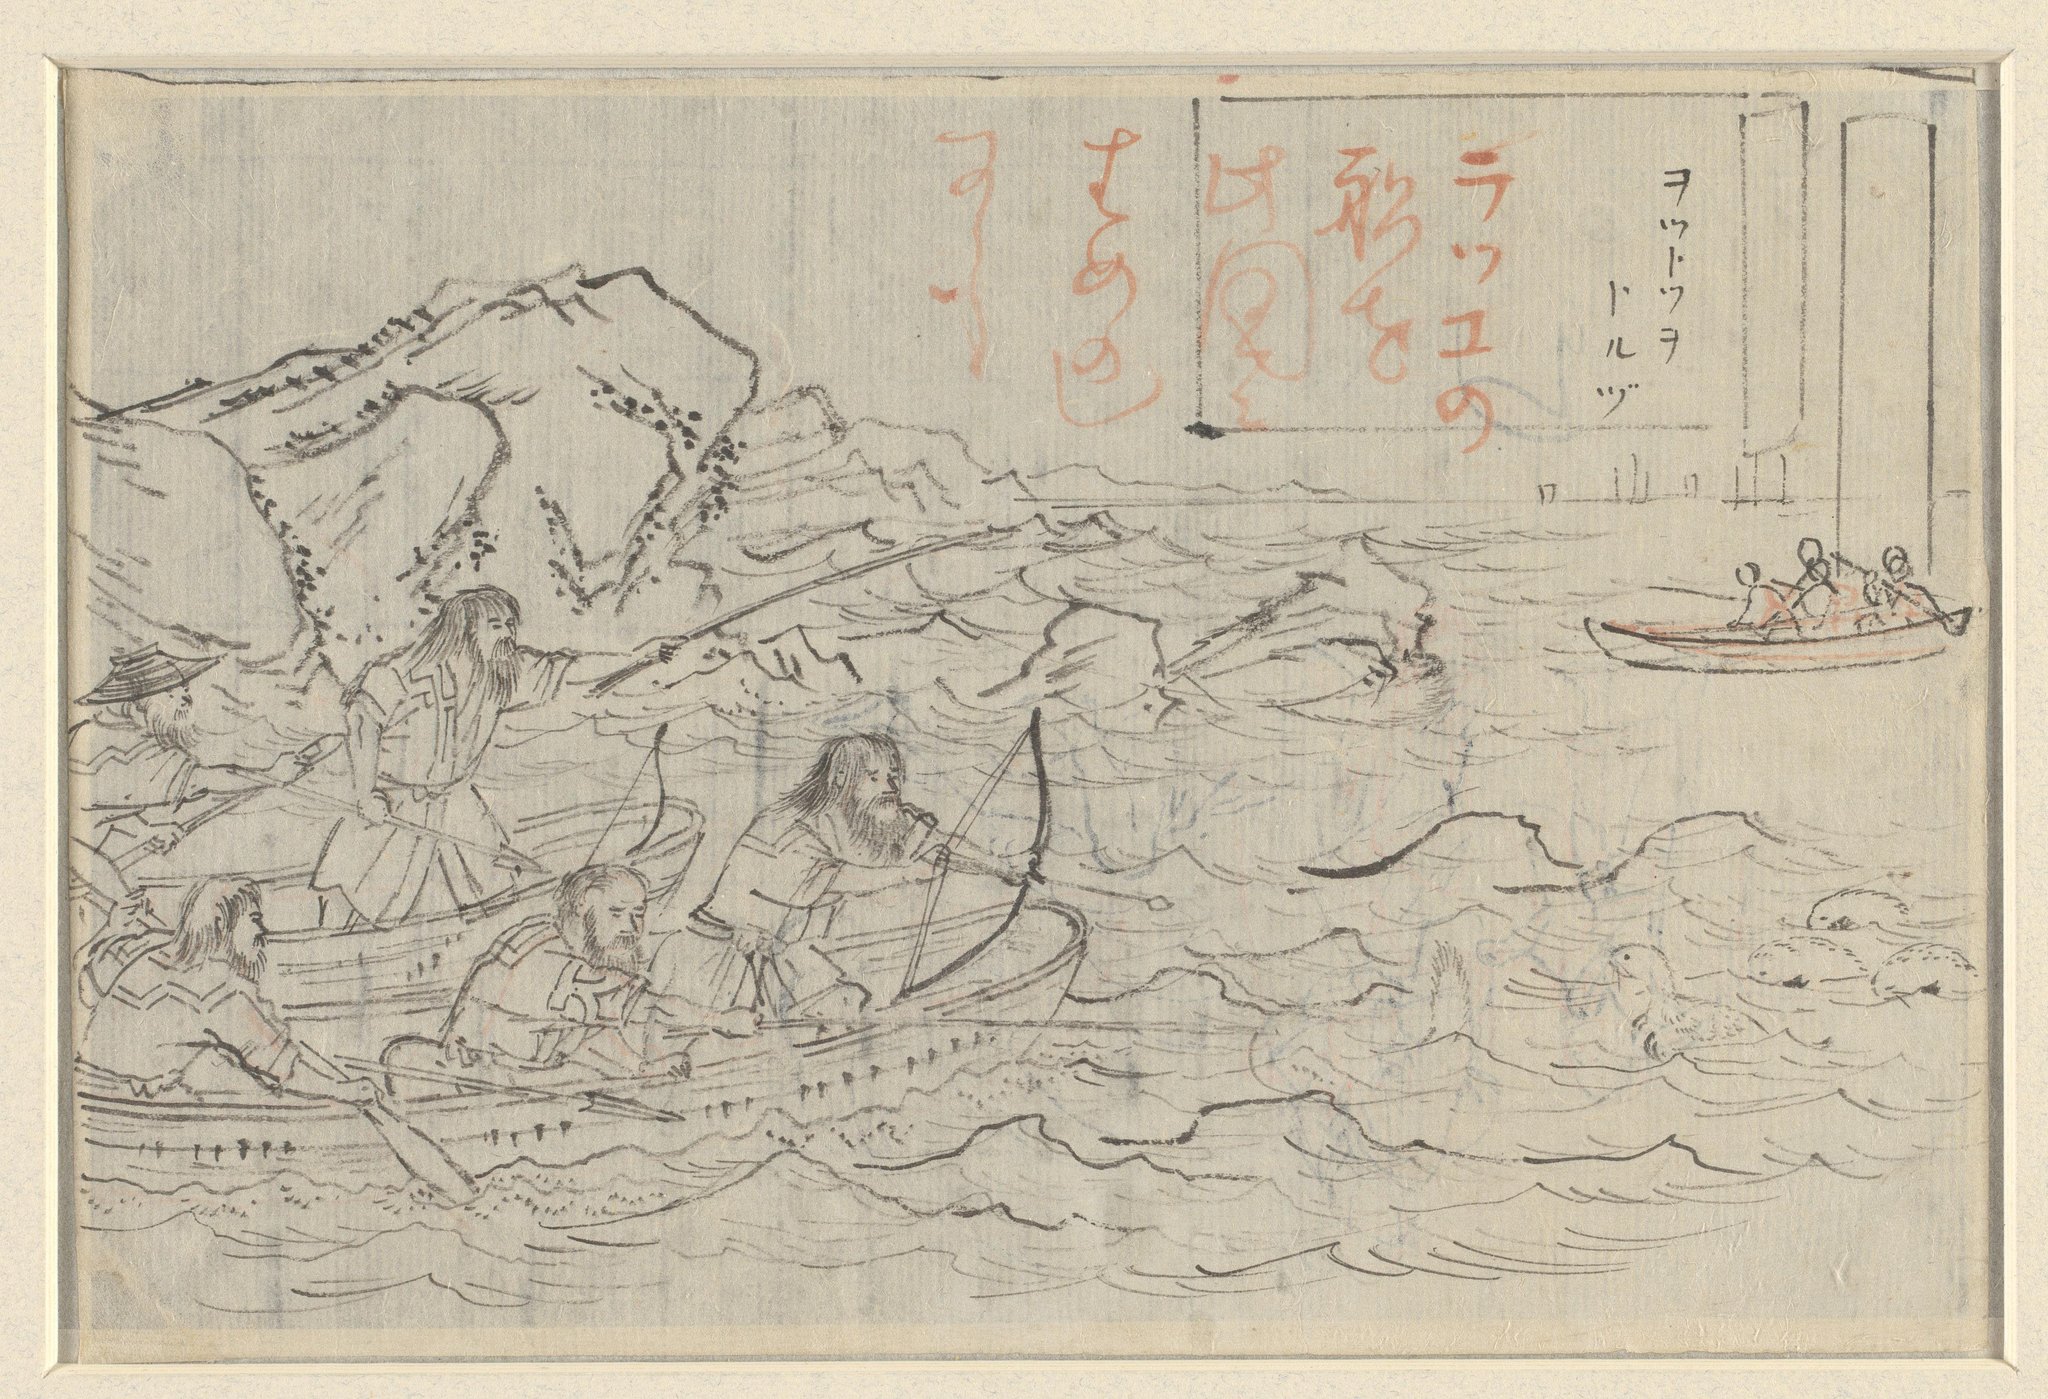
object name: drawing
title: Robbenjacht vanuit een roeibootje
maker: utagawa hiroshige (ii)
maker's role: print maker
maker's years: 1826-1869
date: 1836-1869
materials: paper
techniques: brush